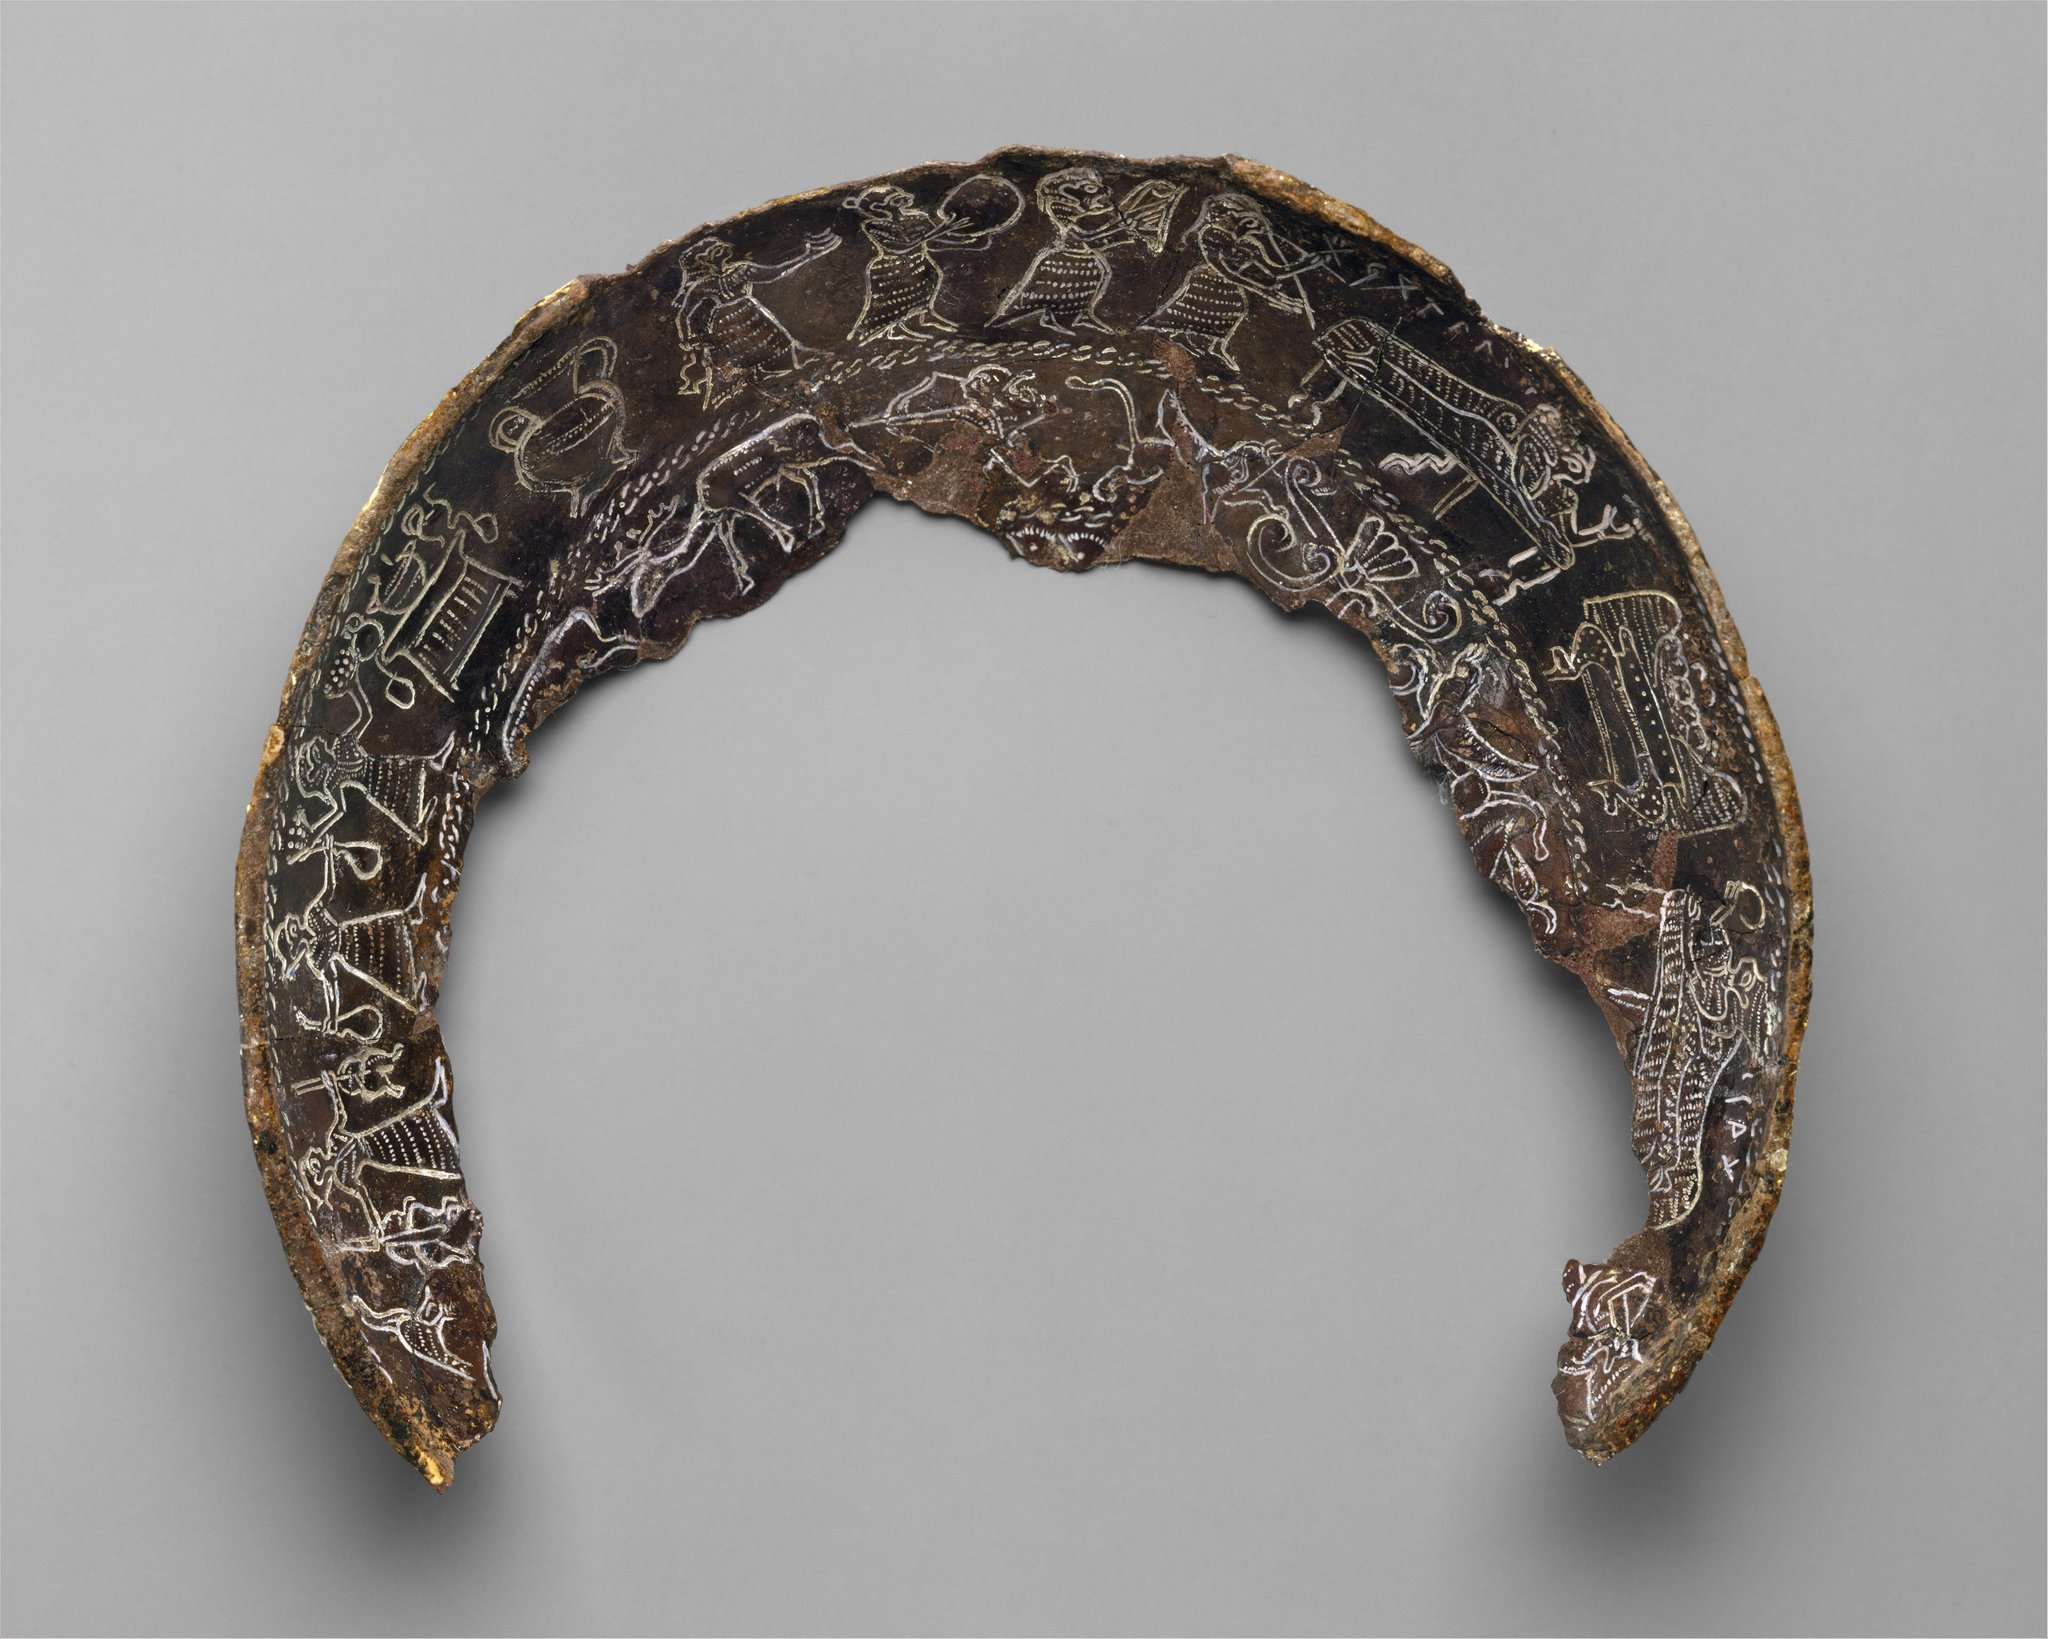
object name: fragment of a bowl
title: Fragmentary silver bowl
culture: cypriot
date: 710-675 BCE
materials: silver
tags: women,deer,banquets